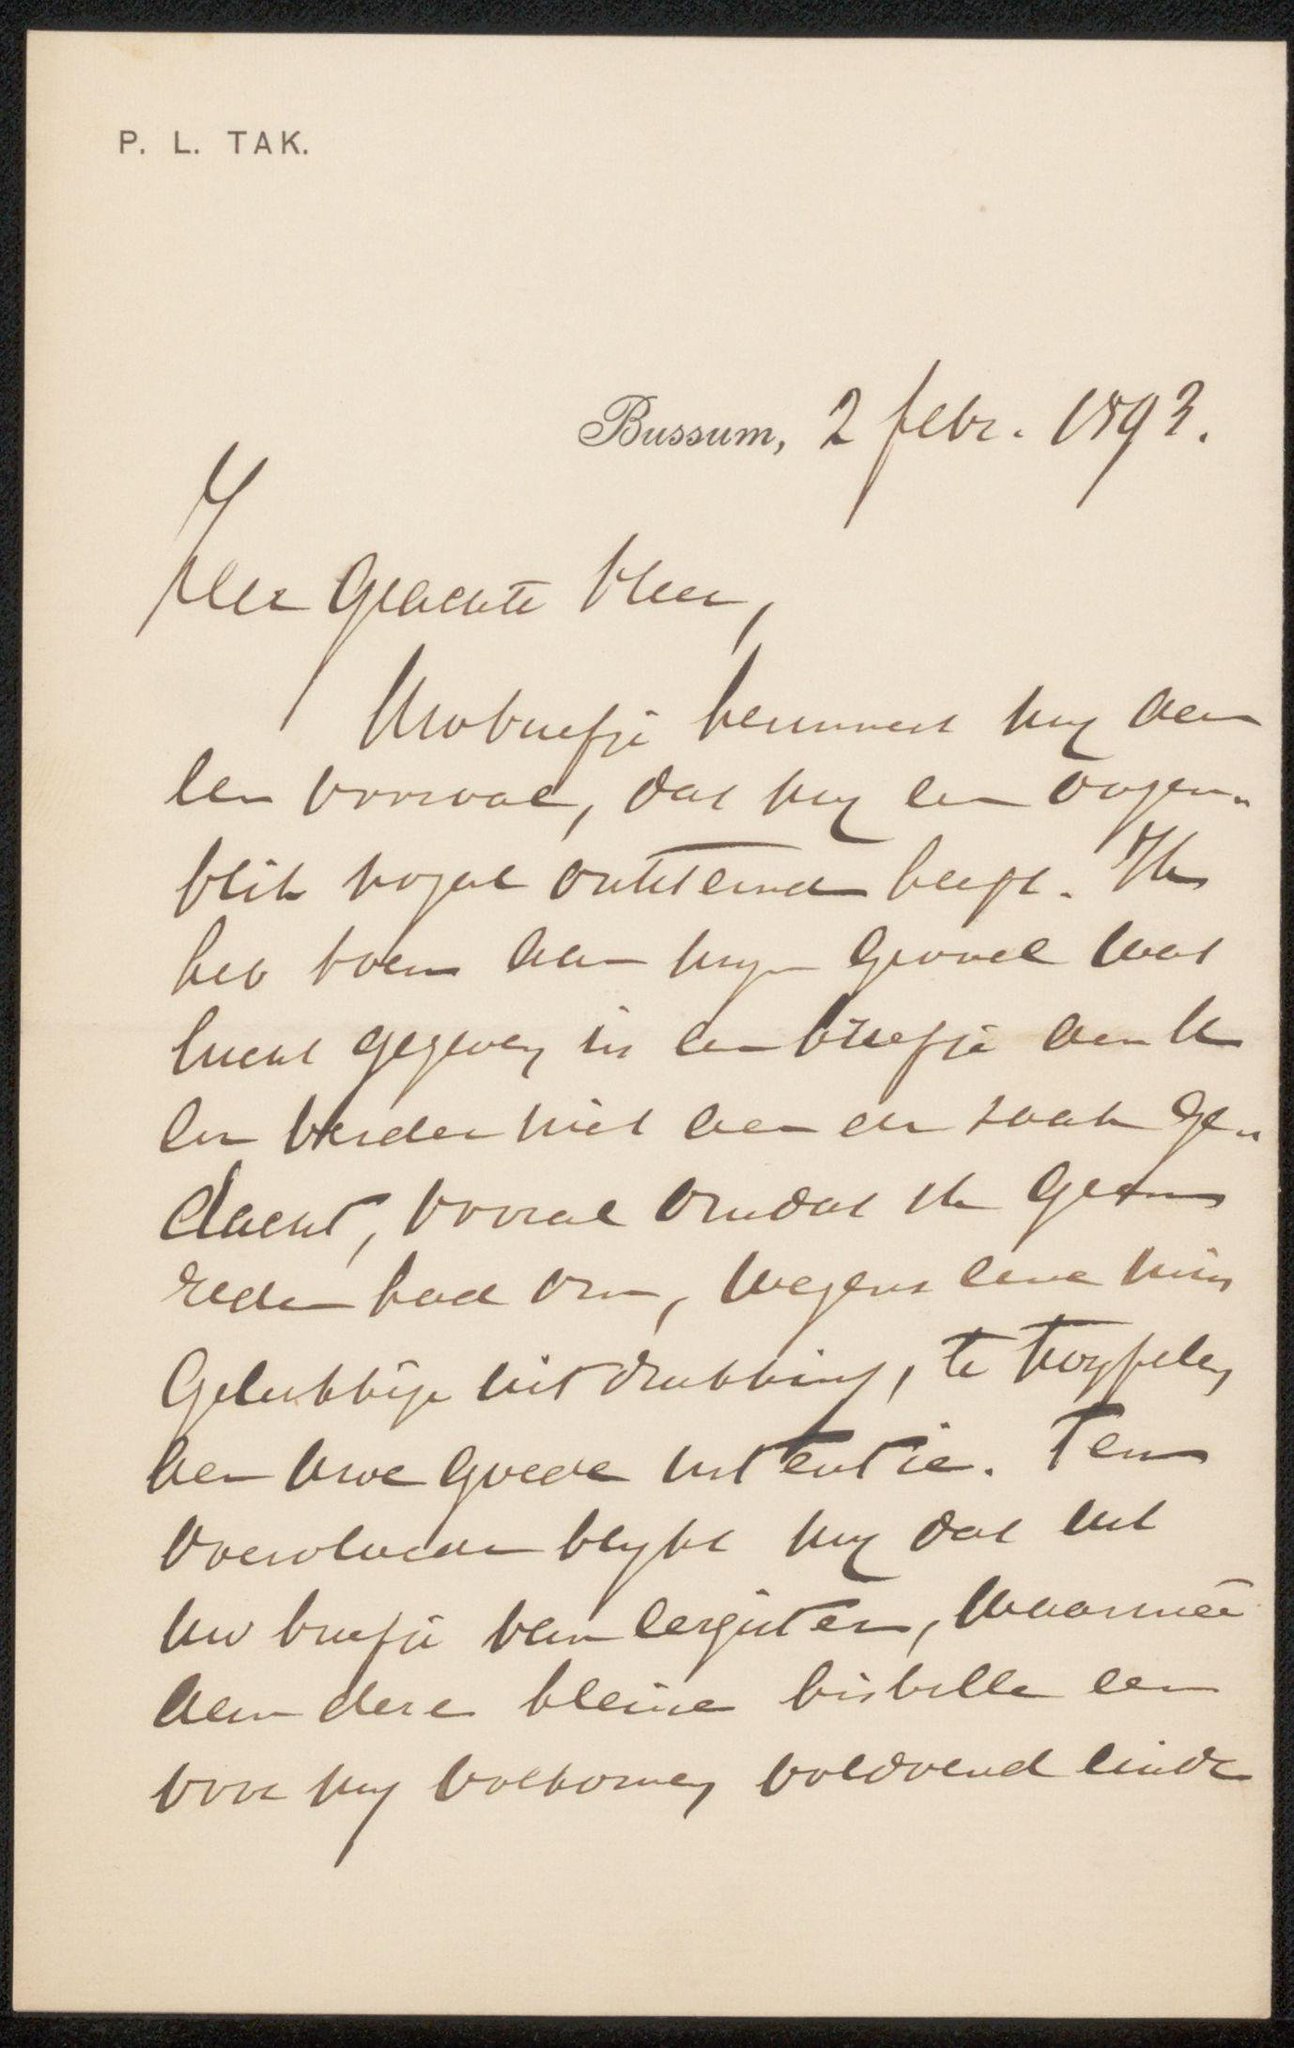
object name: letter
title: Brief aan Philip Zilcken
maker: pieter lodewijk tak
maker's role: politician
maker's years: 1848-1907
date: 1893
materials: ink, paper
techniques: pen, printing, writing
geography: bussum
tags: the hague, painter, draughtsman, philip zilcken, passions, emotions, affections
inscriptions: watermark, collector's mark: ‘RPK’